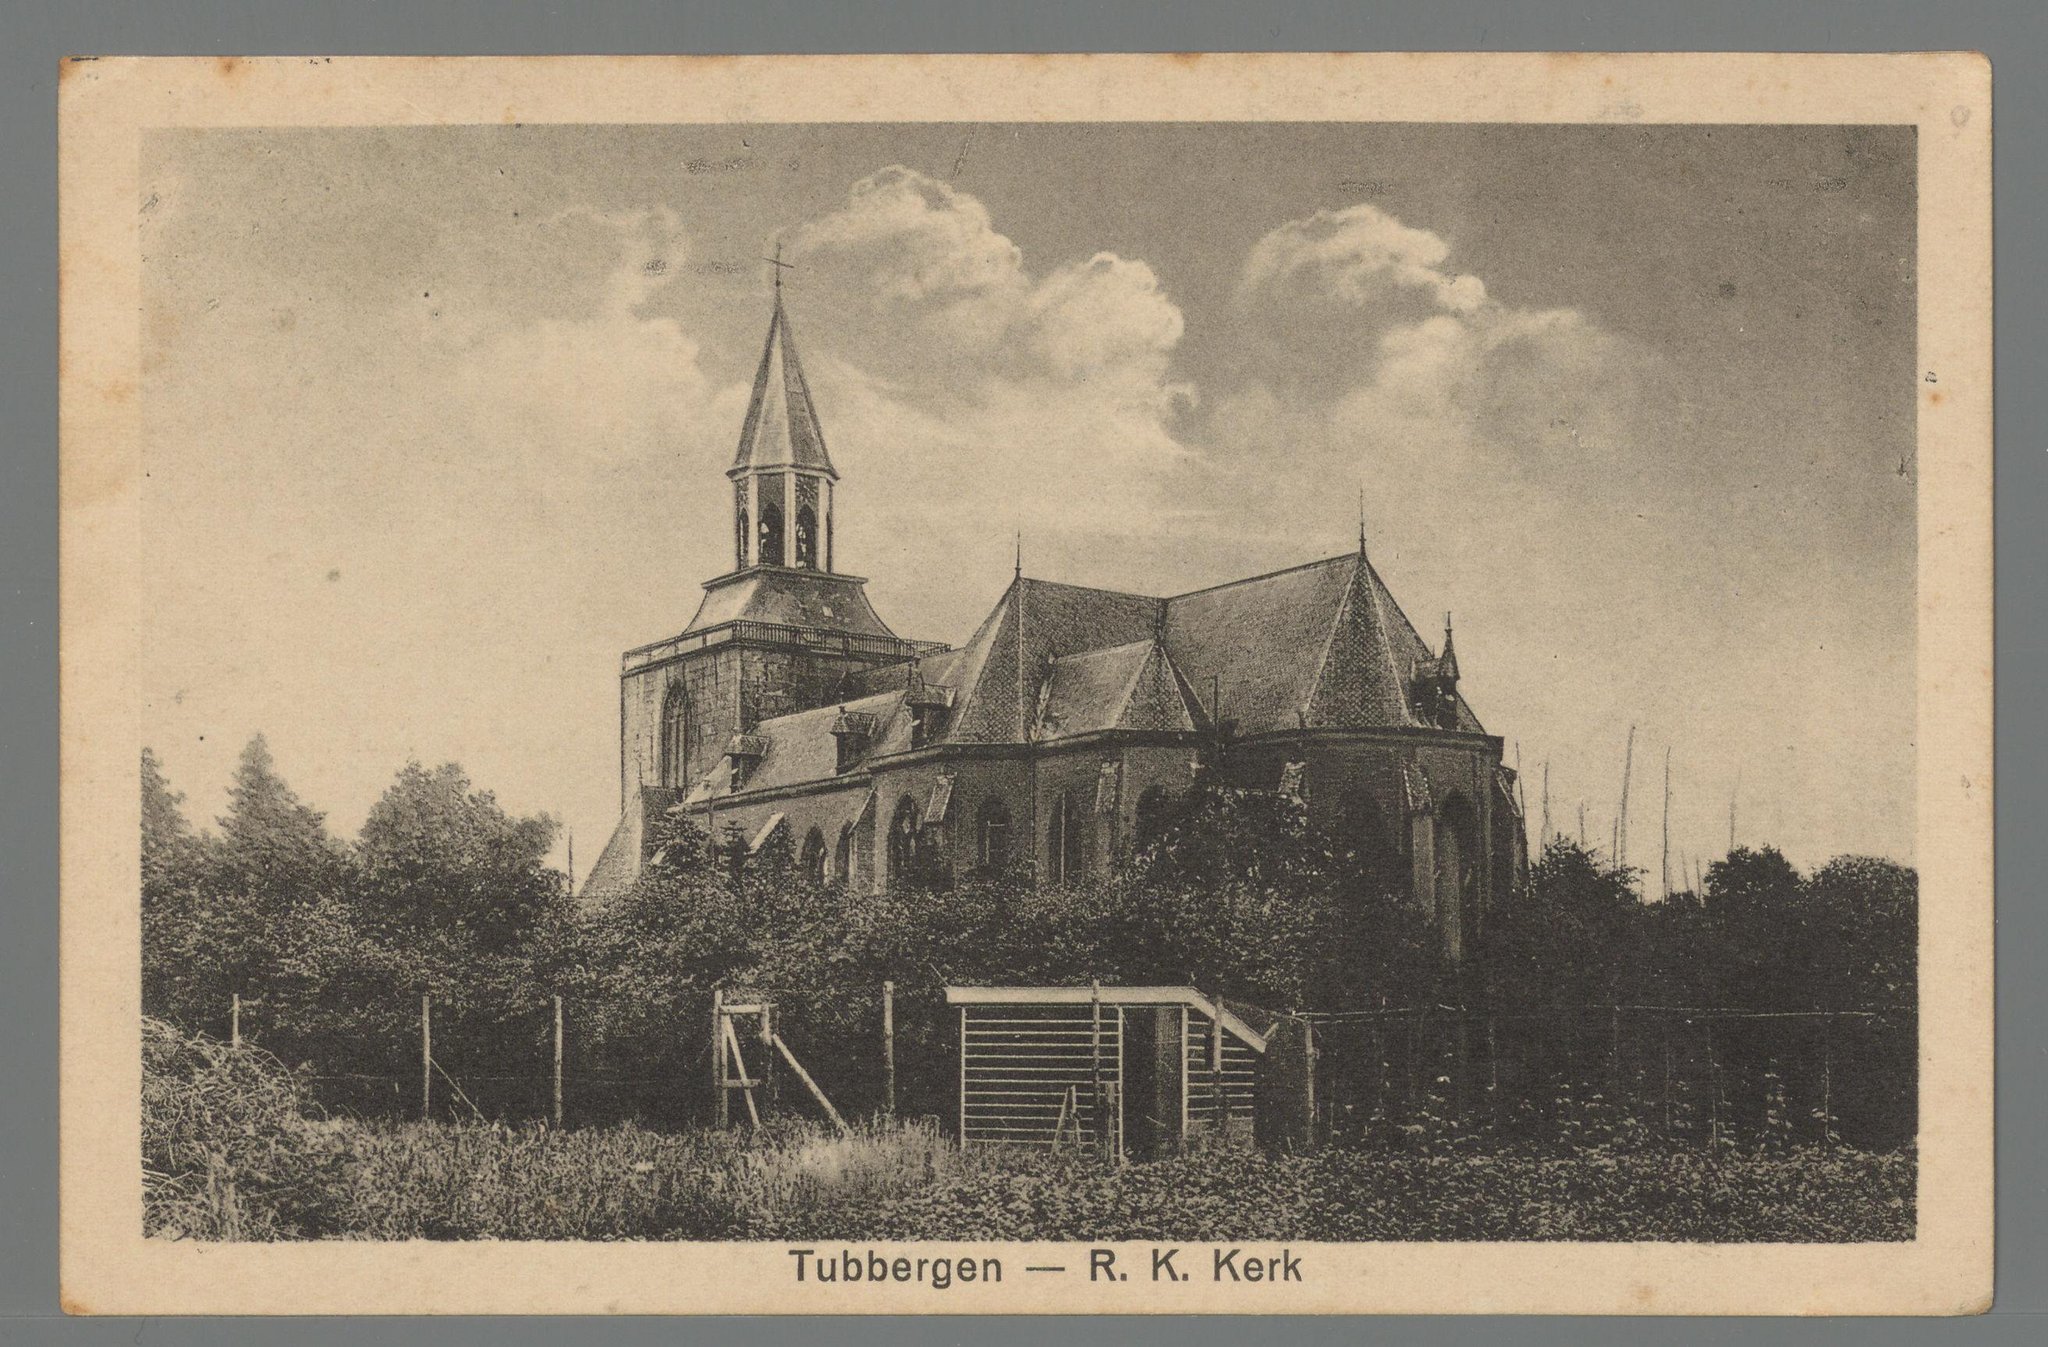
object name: photomechanical print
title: Tubbergen - R.K. Kerk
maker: Anonymous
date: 1913-1927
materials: cardboard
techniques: photograph, writing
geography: tubbergen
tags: church (exterior)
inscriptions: postage stamp